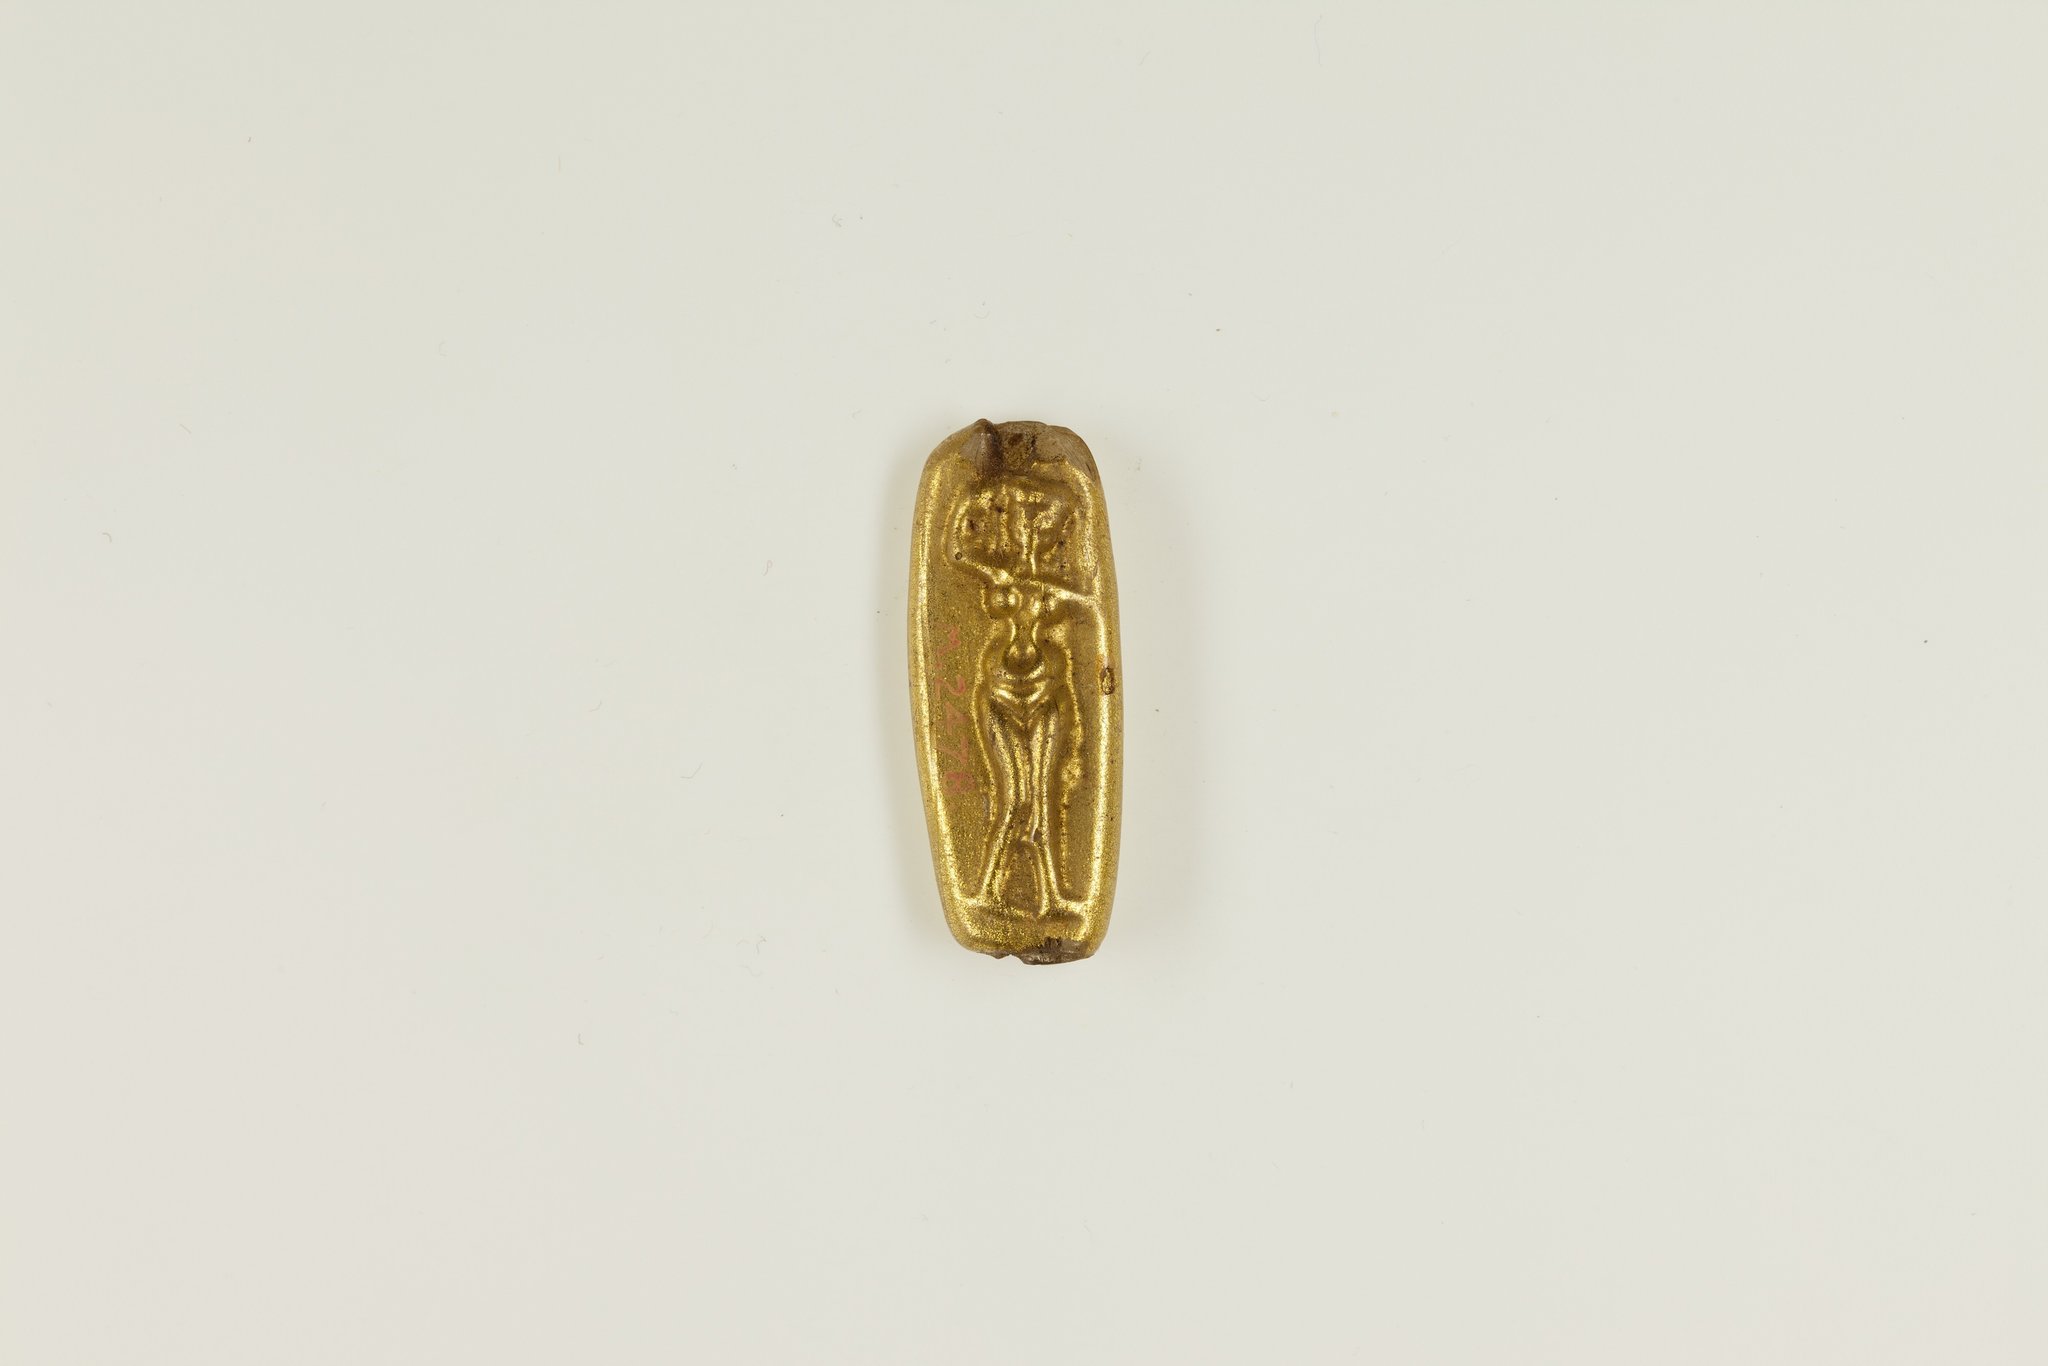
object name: amulet, aphrodite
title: Bead with figure of a goddes (Aphrodite Anadyomene?)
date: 100 BCE-100 CE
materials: glass, gold foil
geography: egypt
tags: goddess